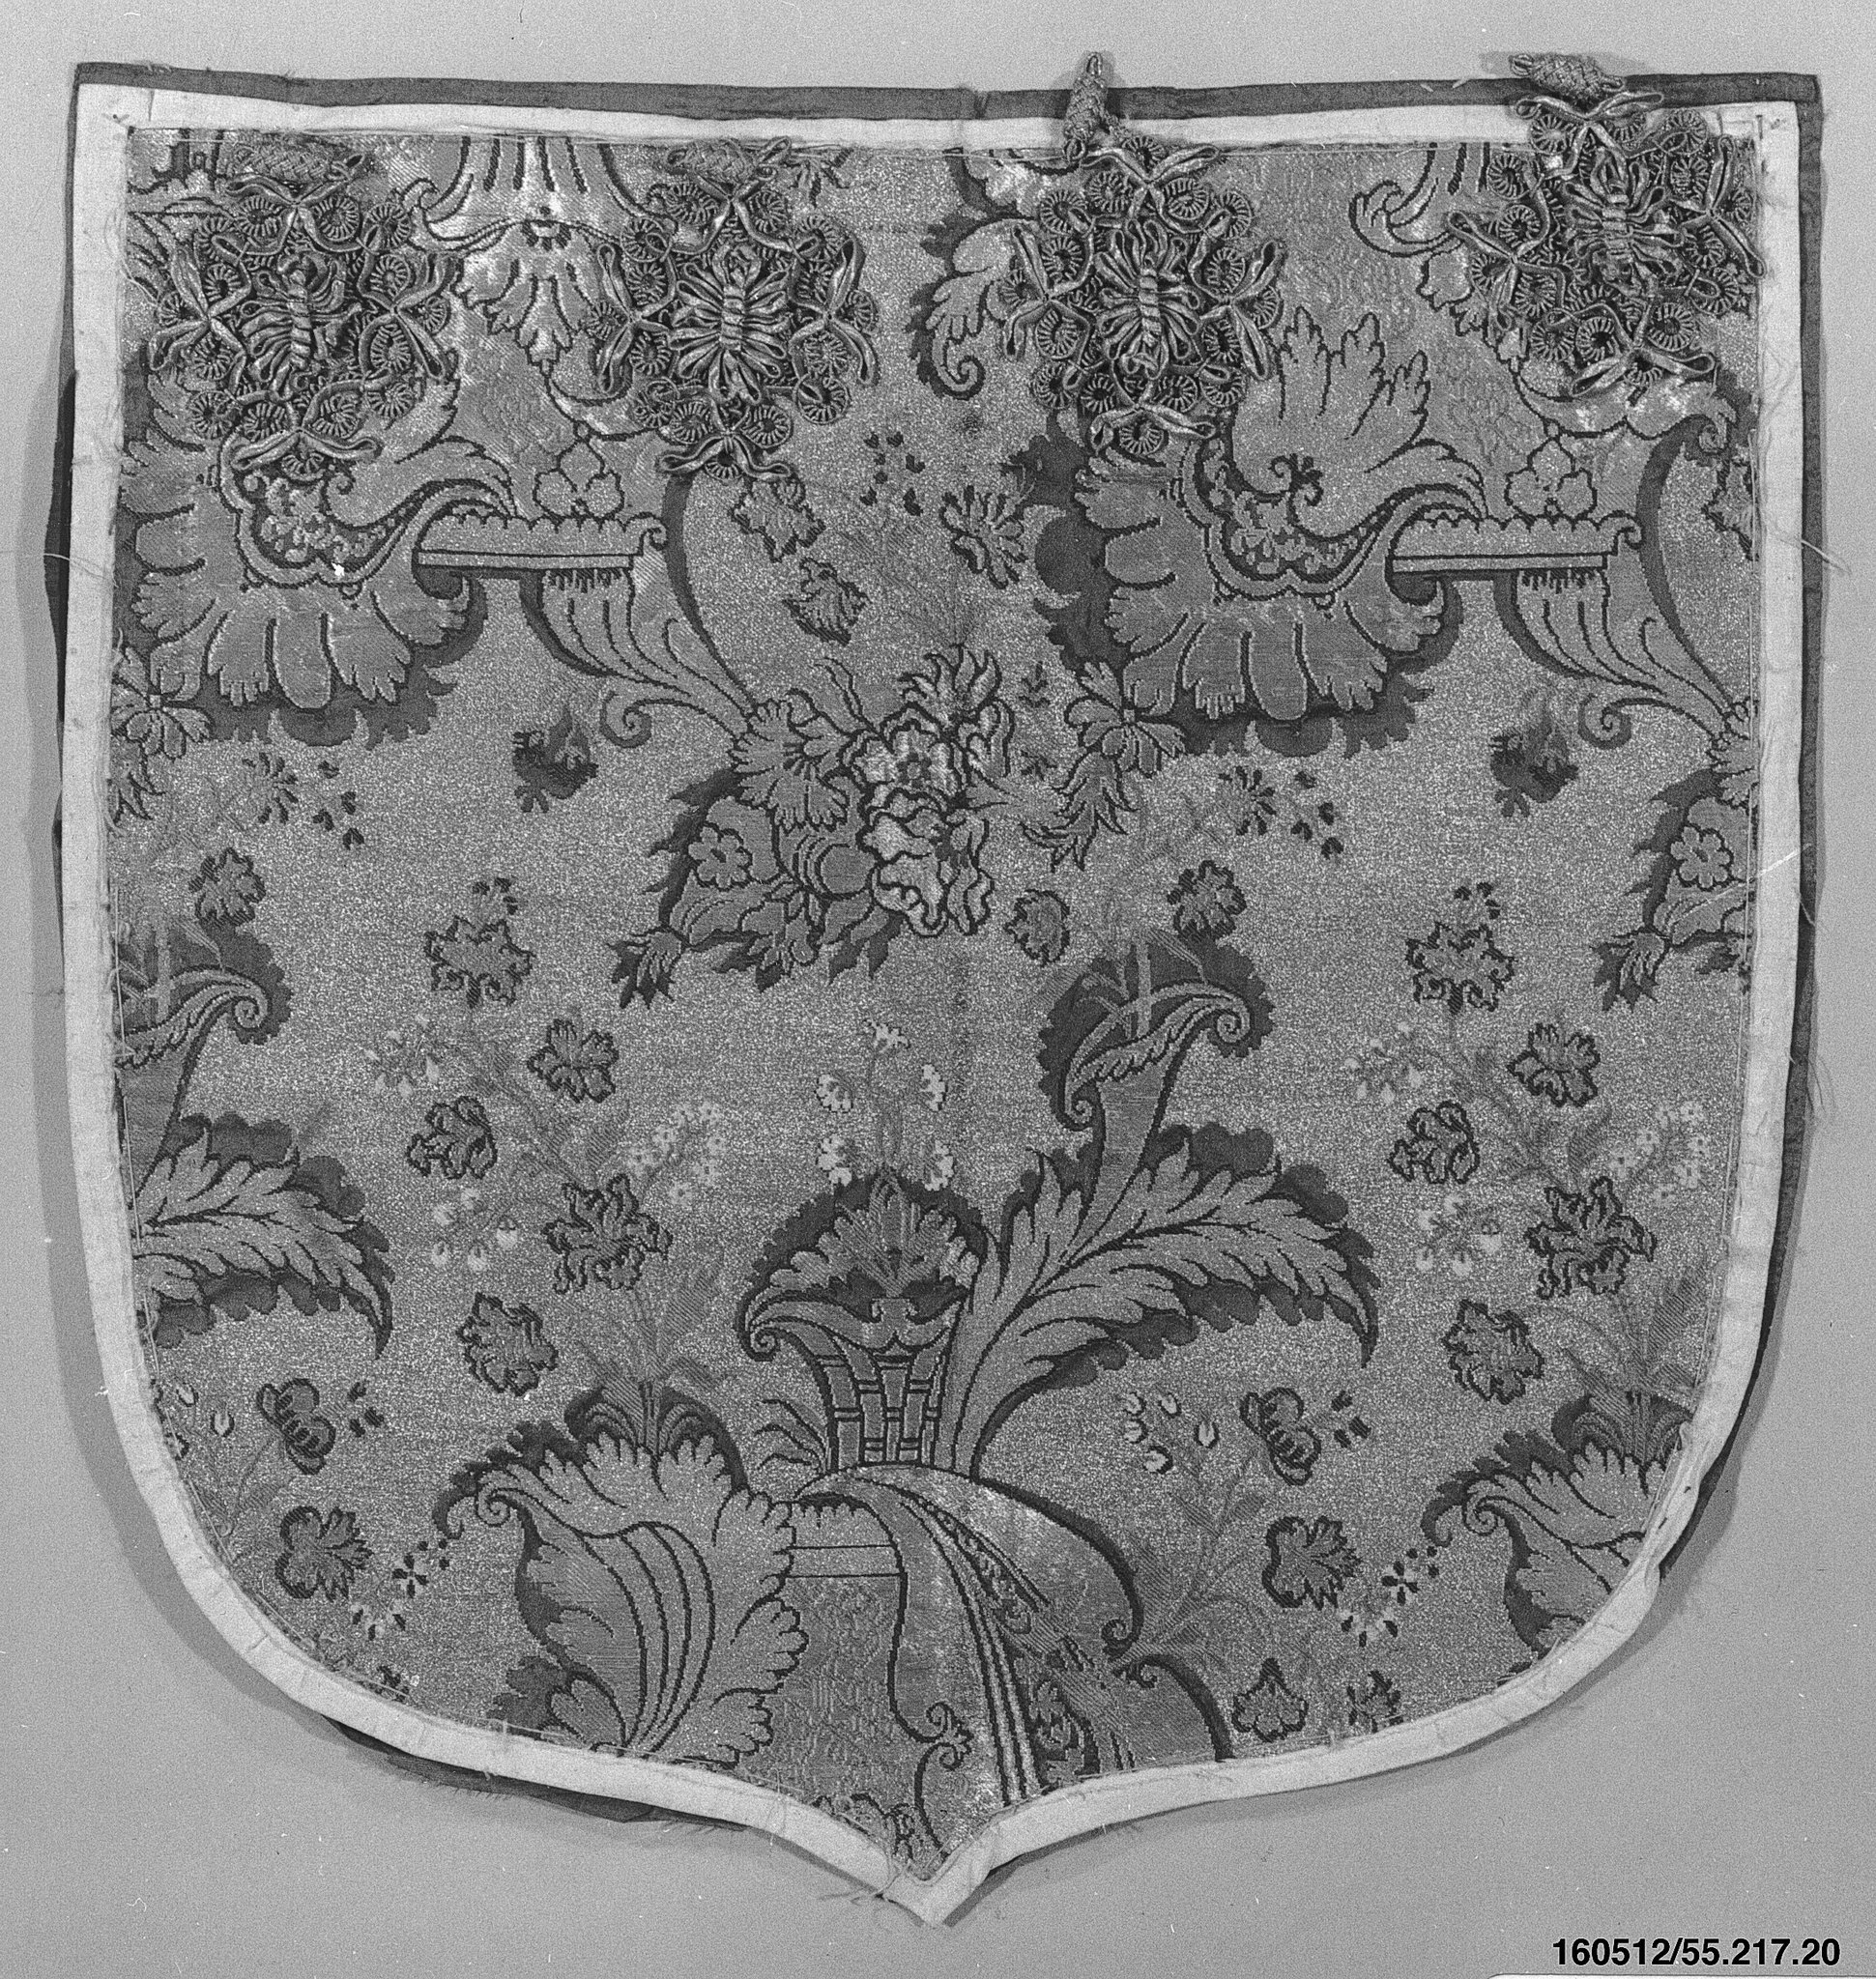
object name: hood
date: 1720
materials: metal thread, silk